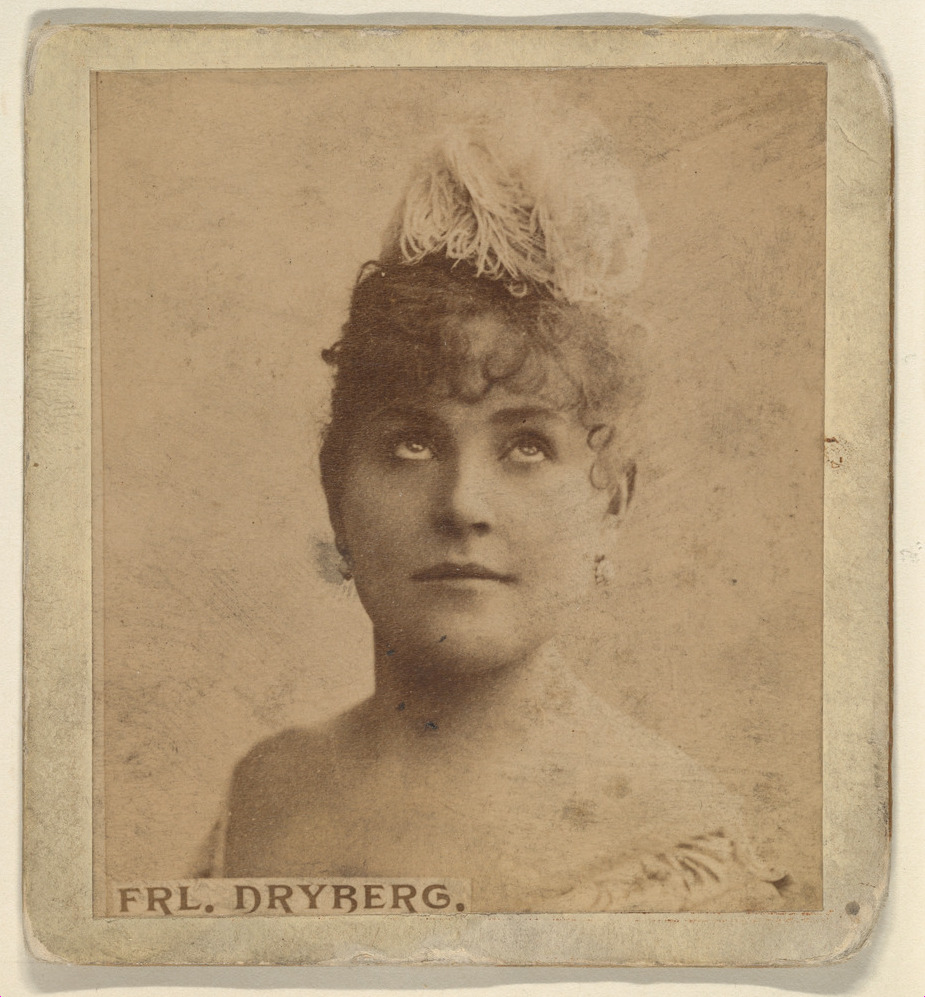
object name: photograph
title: Frl. Dryberg, from the Actresses series (N246), Type 2, issued by Kinney Brothers to promote Sporting Extra Cigarettes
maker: kinney brothers tobacco company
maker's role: publisher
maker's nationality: american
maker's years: 1869-2011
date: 1890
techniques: albumen silver print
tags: portraits,women,actresses